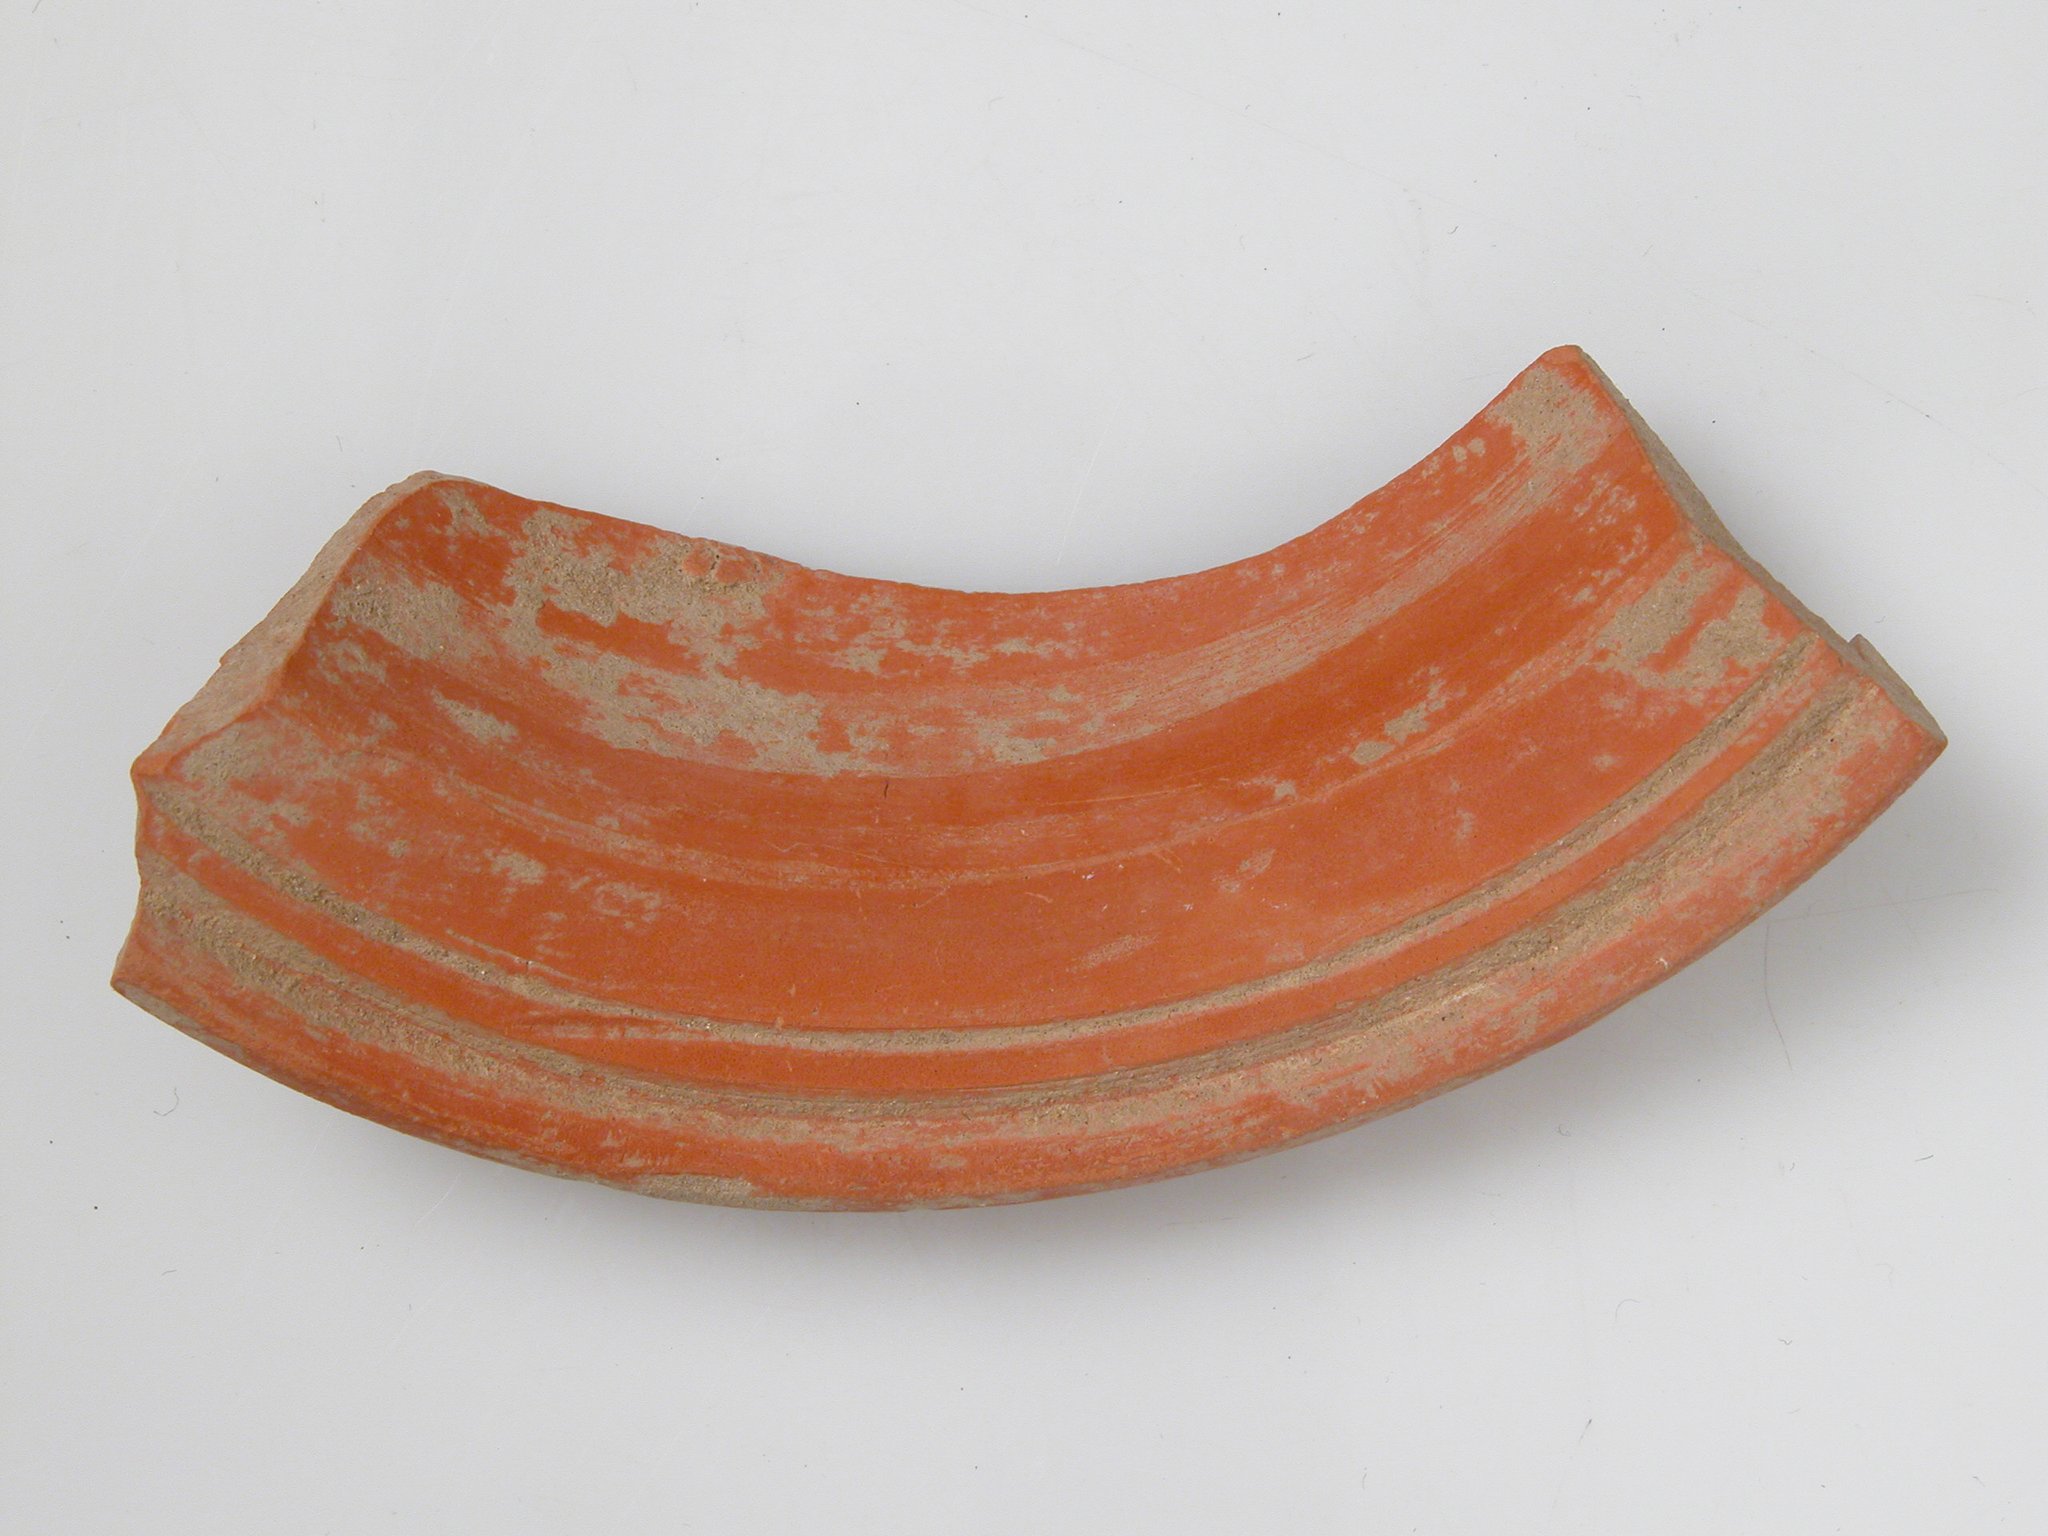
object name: fragment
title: Bowl Fragment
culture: coptic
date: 301-700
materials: earthenware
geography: egypt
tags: bowls